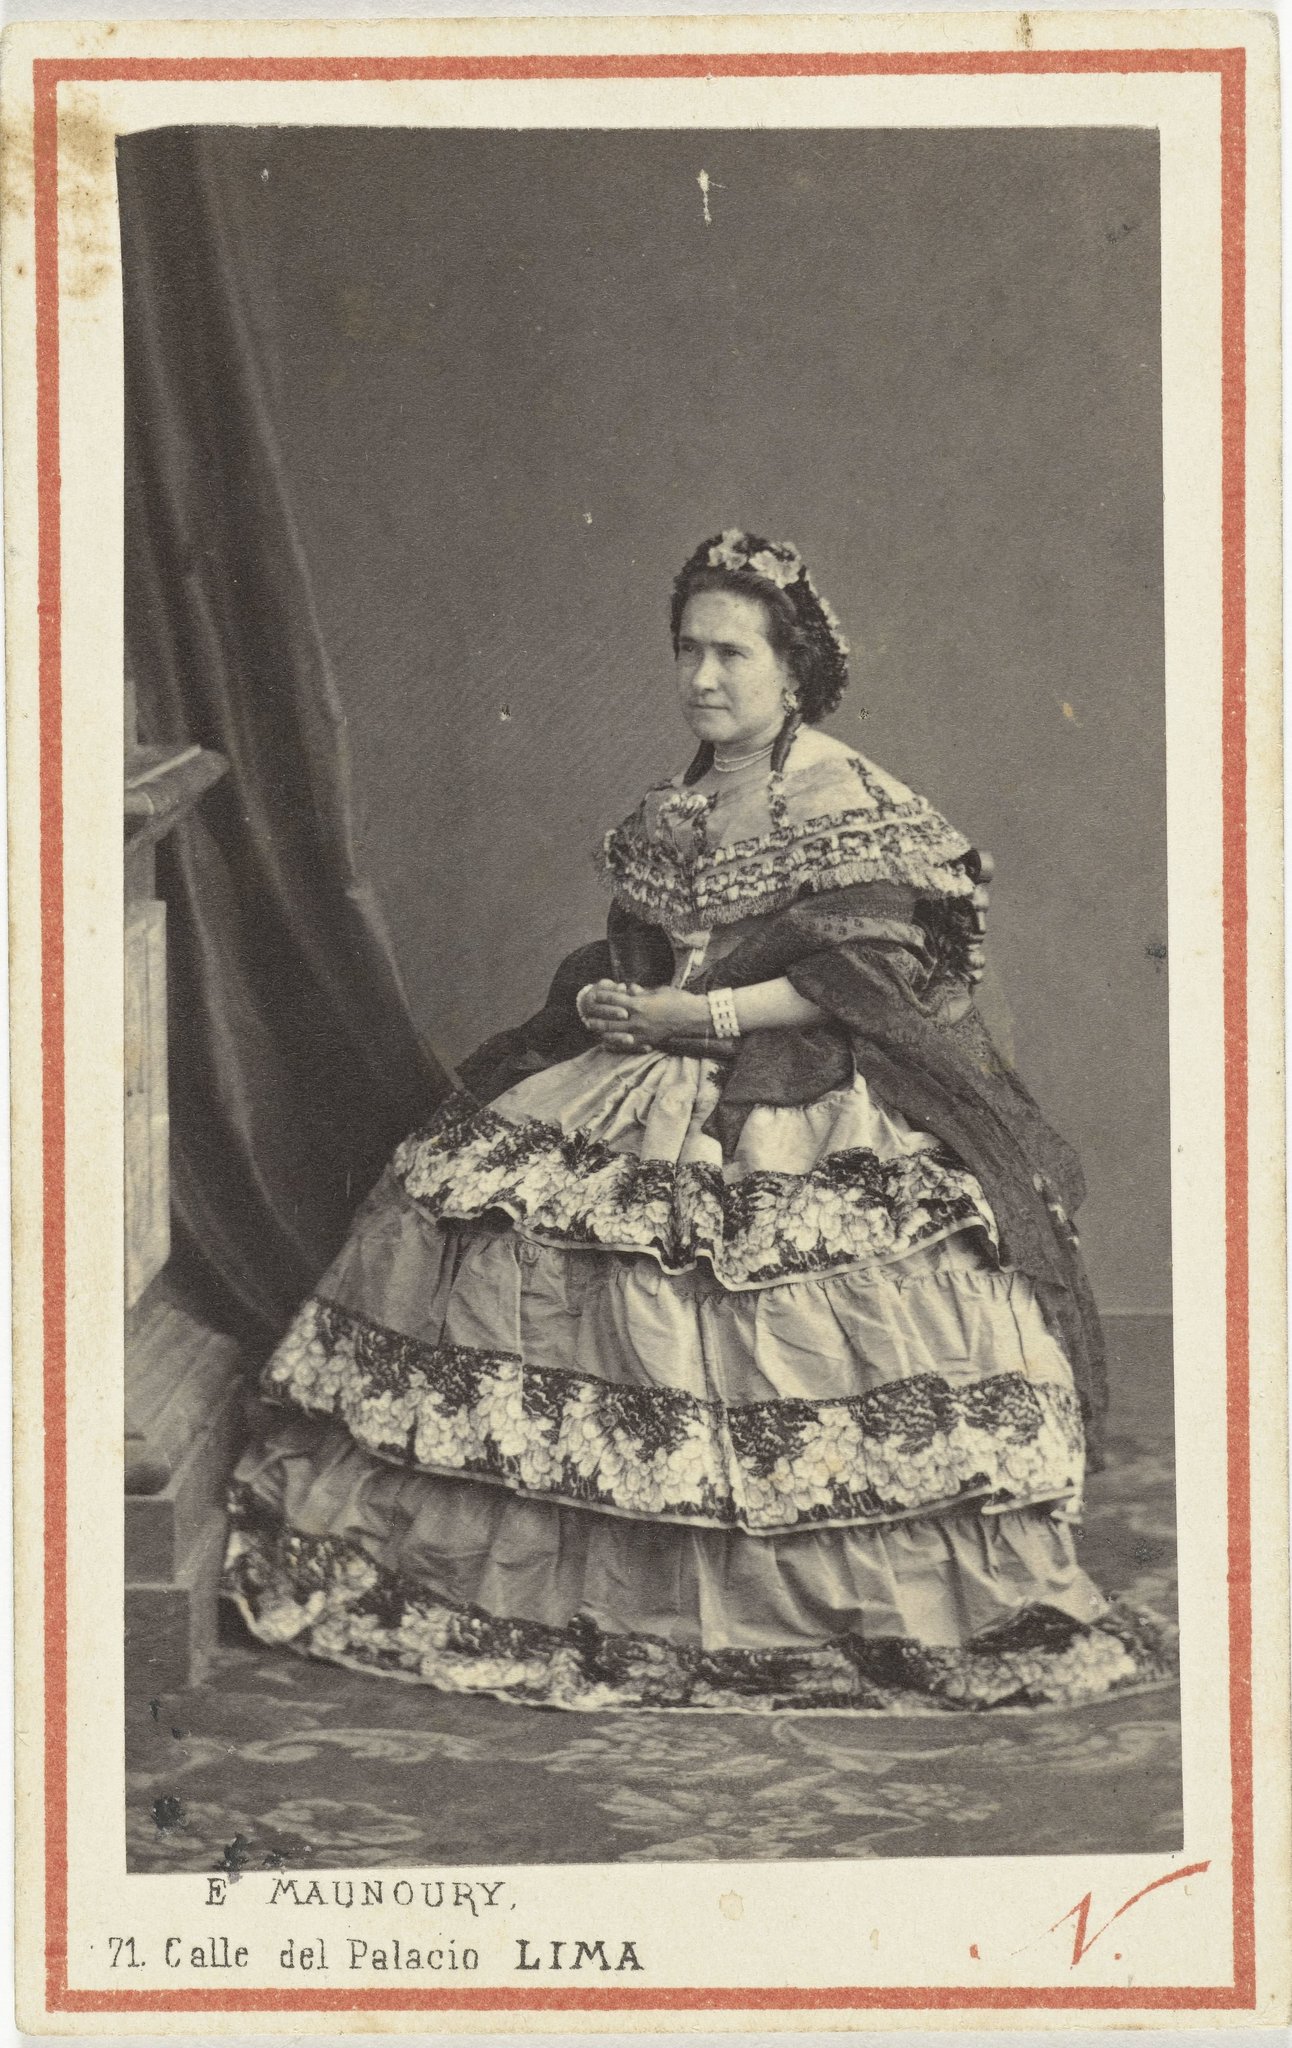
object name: photograph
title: Portret van Josefa Leon de Bernales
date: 1860-1865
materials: cardboard, photographic support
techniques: albumen print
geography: lima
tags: historical persons - bb - woman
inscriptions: inscription: ‘E. MAUNOURY/ Corresponsal de la Casa’, name: ‘Josefa Leon de Bernales’, name: ‘Nadar/ DE PARIS’, address: ‘E. MAUNOURY,/ 71, Calle del Palacio LIMA / N.’